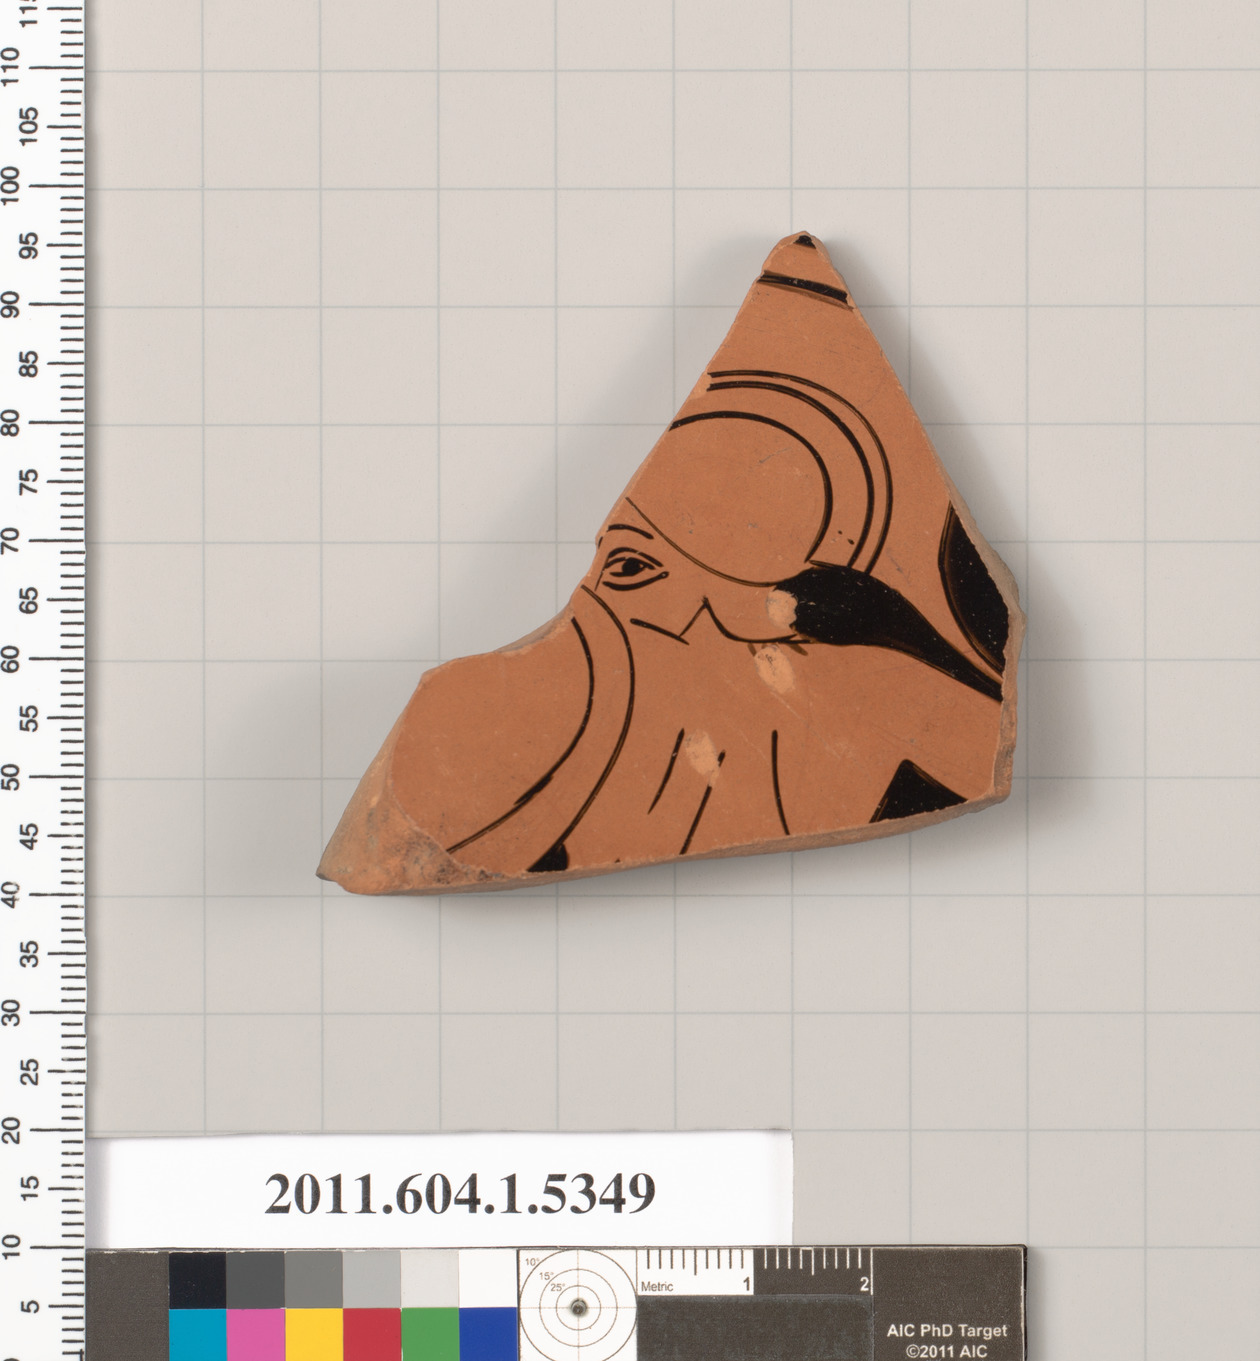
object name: kylix fragment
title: Terracotta fragment of a kylix (drinking cup)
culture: greek, attic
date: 520-510 BCE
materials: terracotta